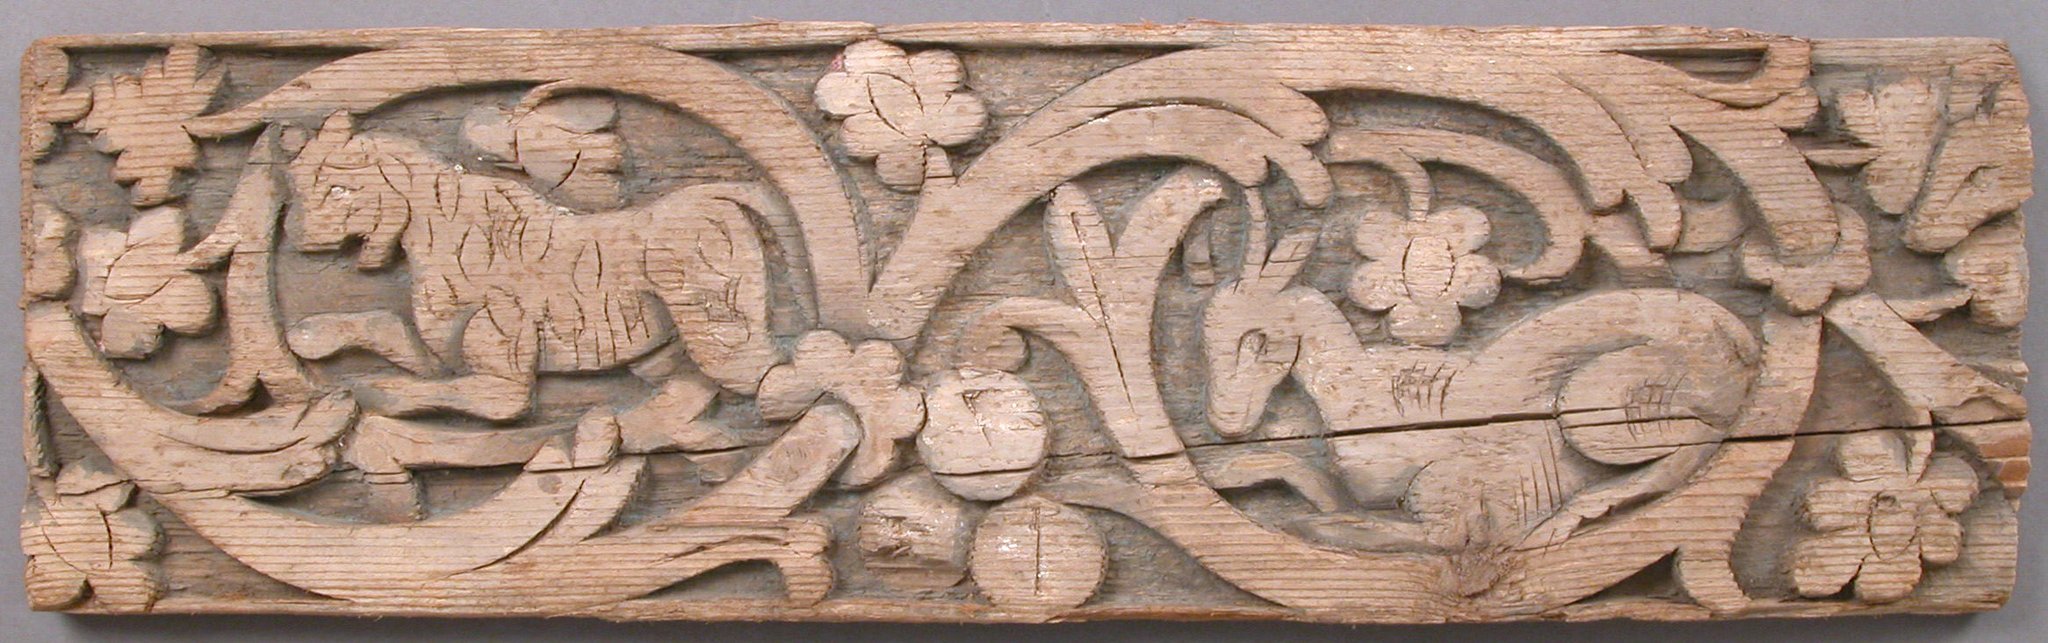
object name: relief frieze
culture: coptic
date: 501-600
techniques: polychromy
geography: egypt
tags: animals